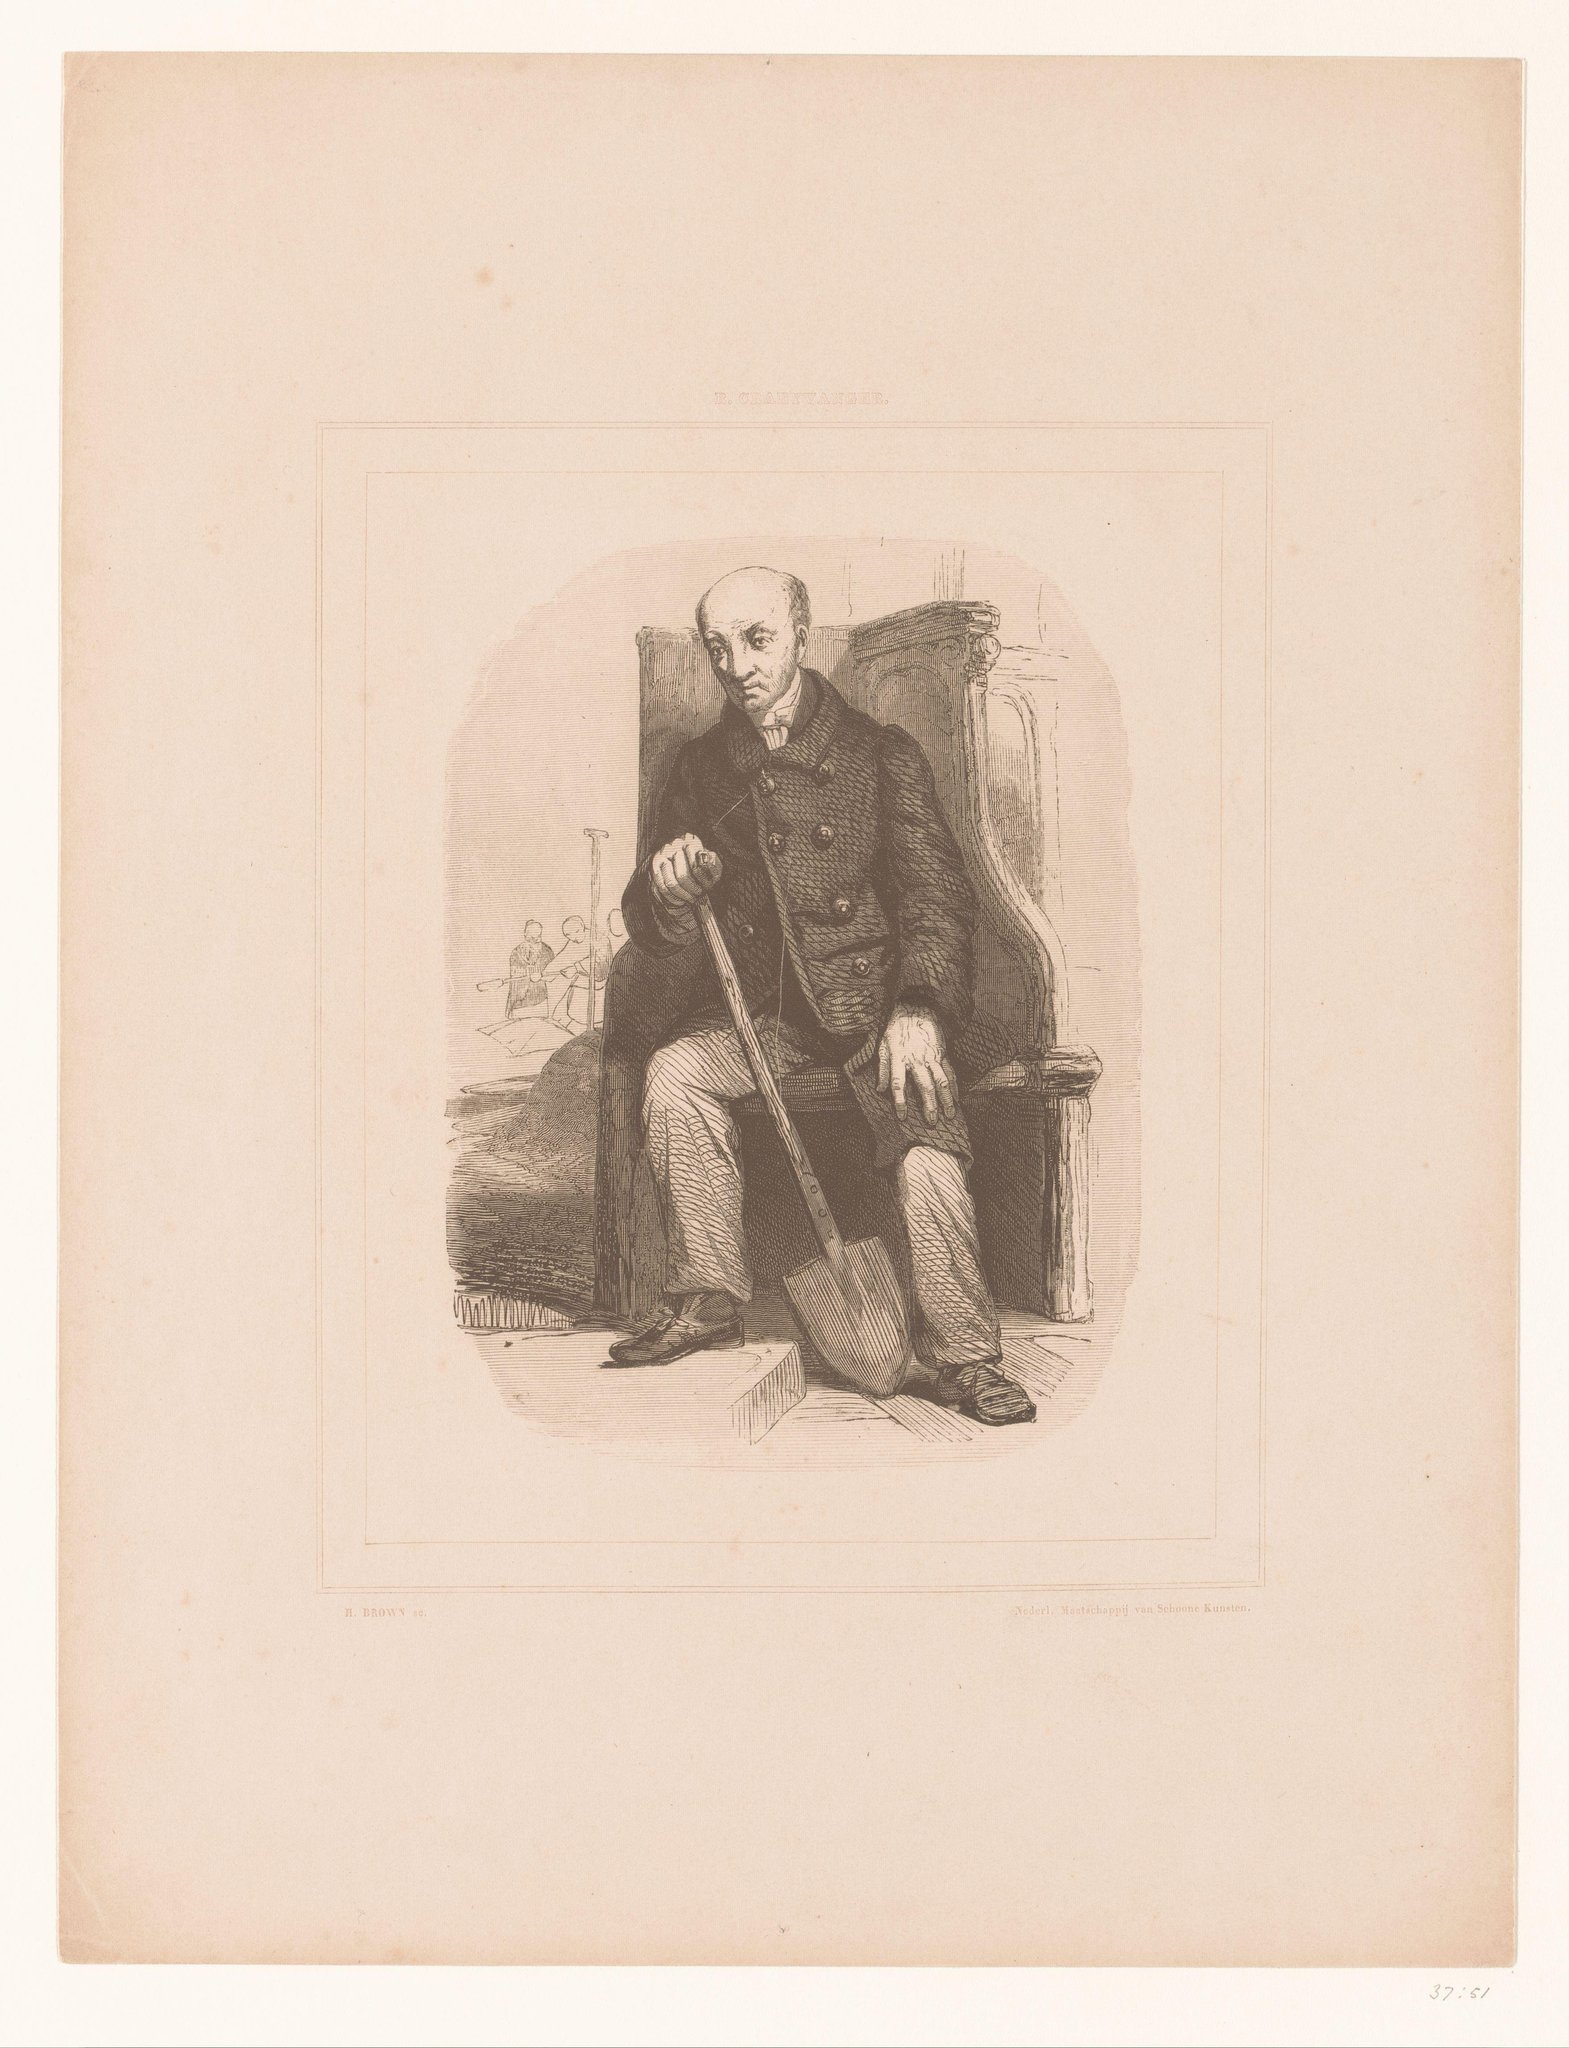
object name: print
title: Grafdelver met schep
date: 1841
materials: paper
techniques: engraving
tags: adult man, grave digger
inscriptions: collector's mark: Lugt 2760, collector's mark: Lugt 2228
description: Andere staat verschenen in: Brown, Henry. De Nederlanden: karakterschetsen, kleederdragten, houding en voorkomen van verschillende standen. Den Haag: Nederlandsche Maatschappij van Schoone Kunsten, 1841.